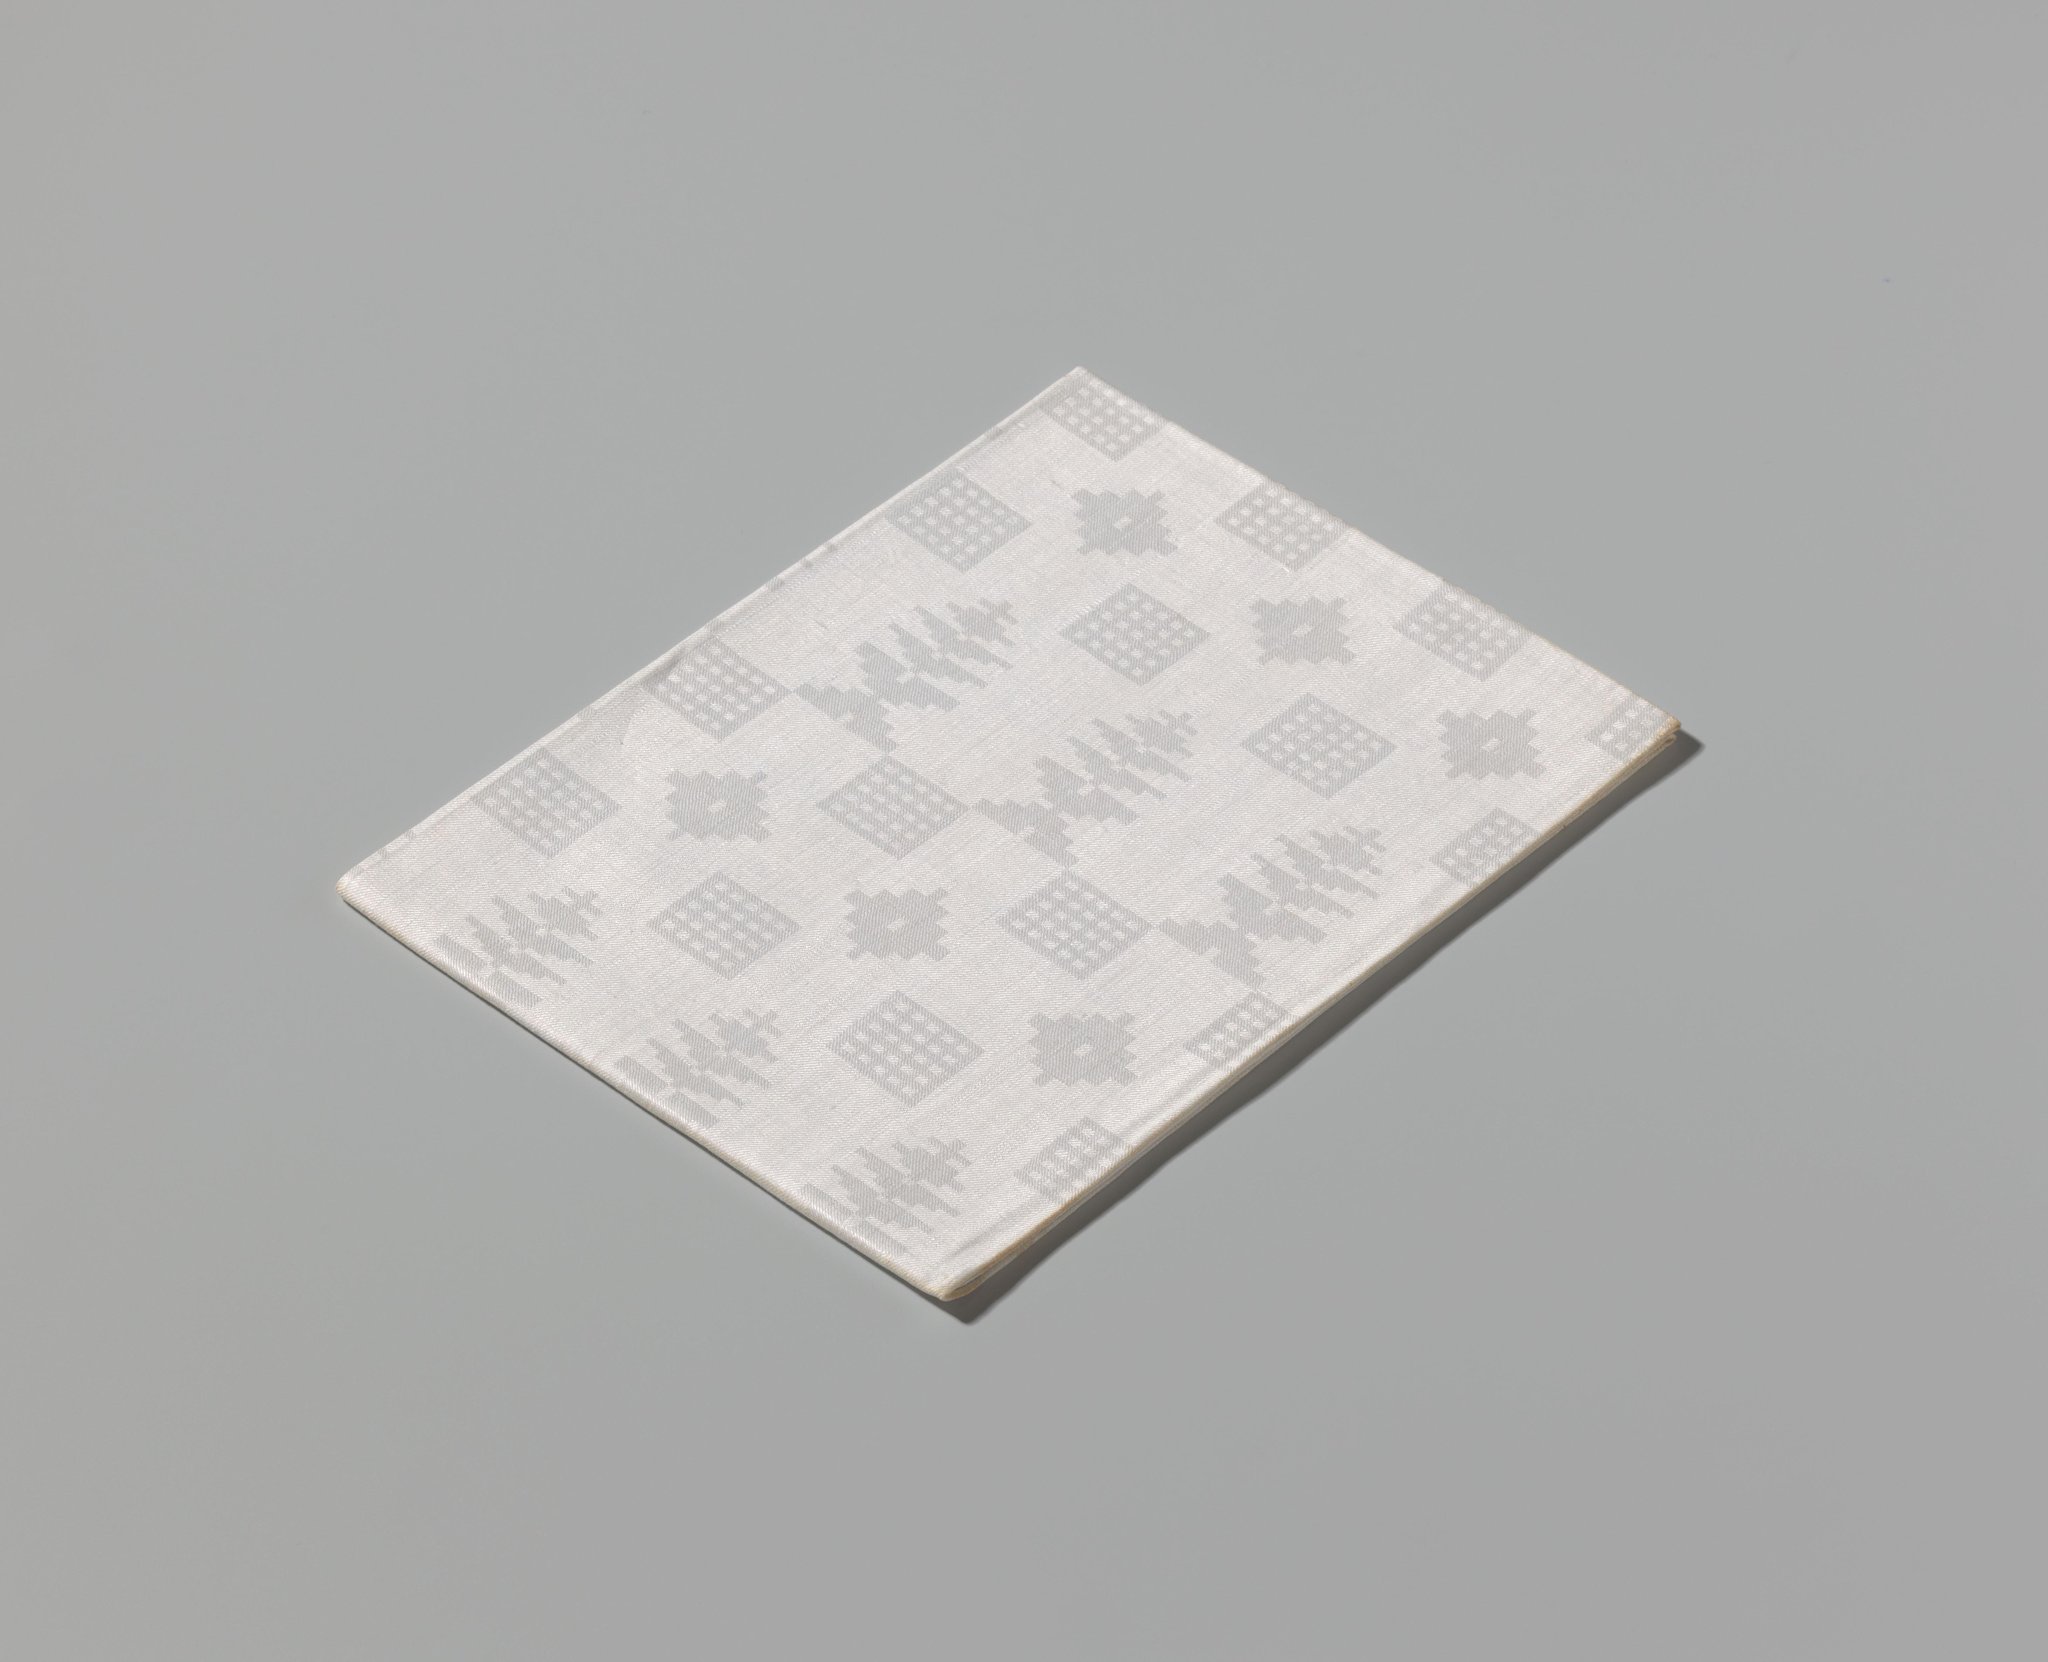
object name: napkin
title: Servet van linnen met pellenpatroon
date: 1730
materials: linen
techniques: twill, peeled fabric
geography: northern netherlands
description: wit linnen servet met pellen patroon, merk kroon WG 42 en 1730